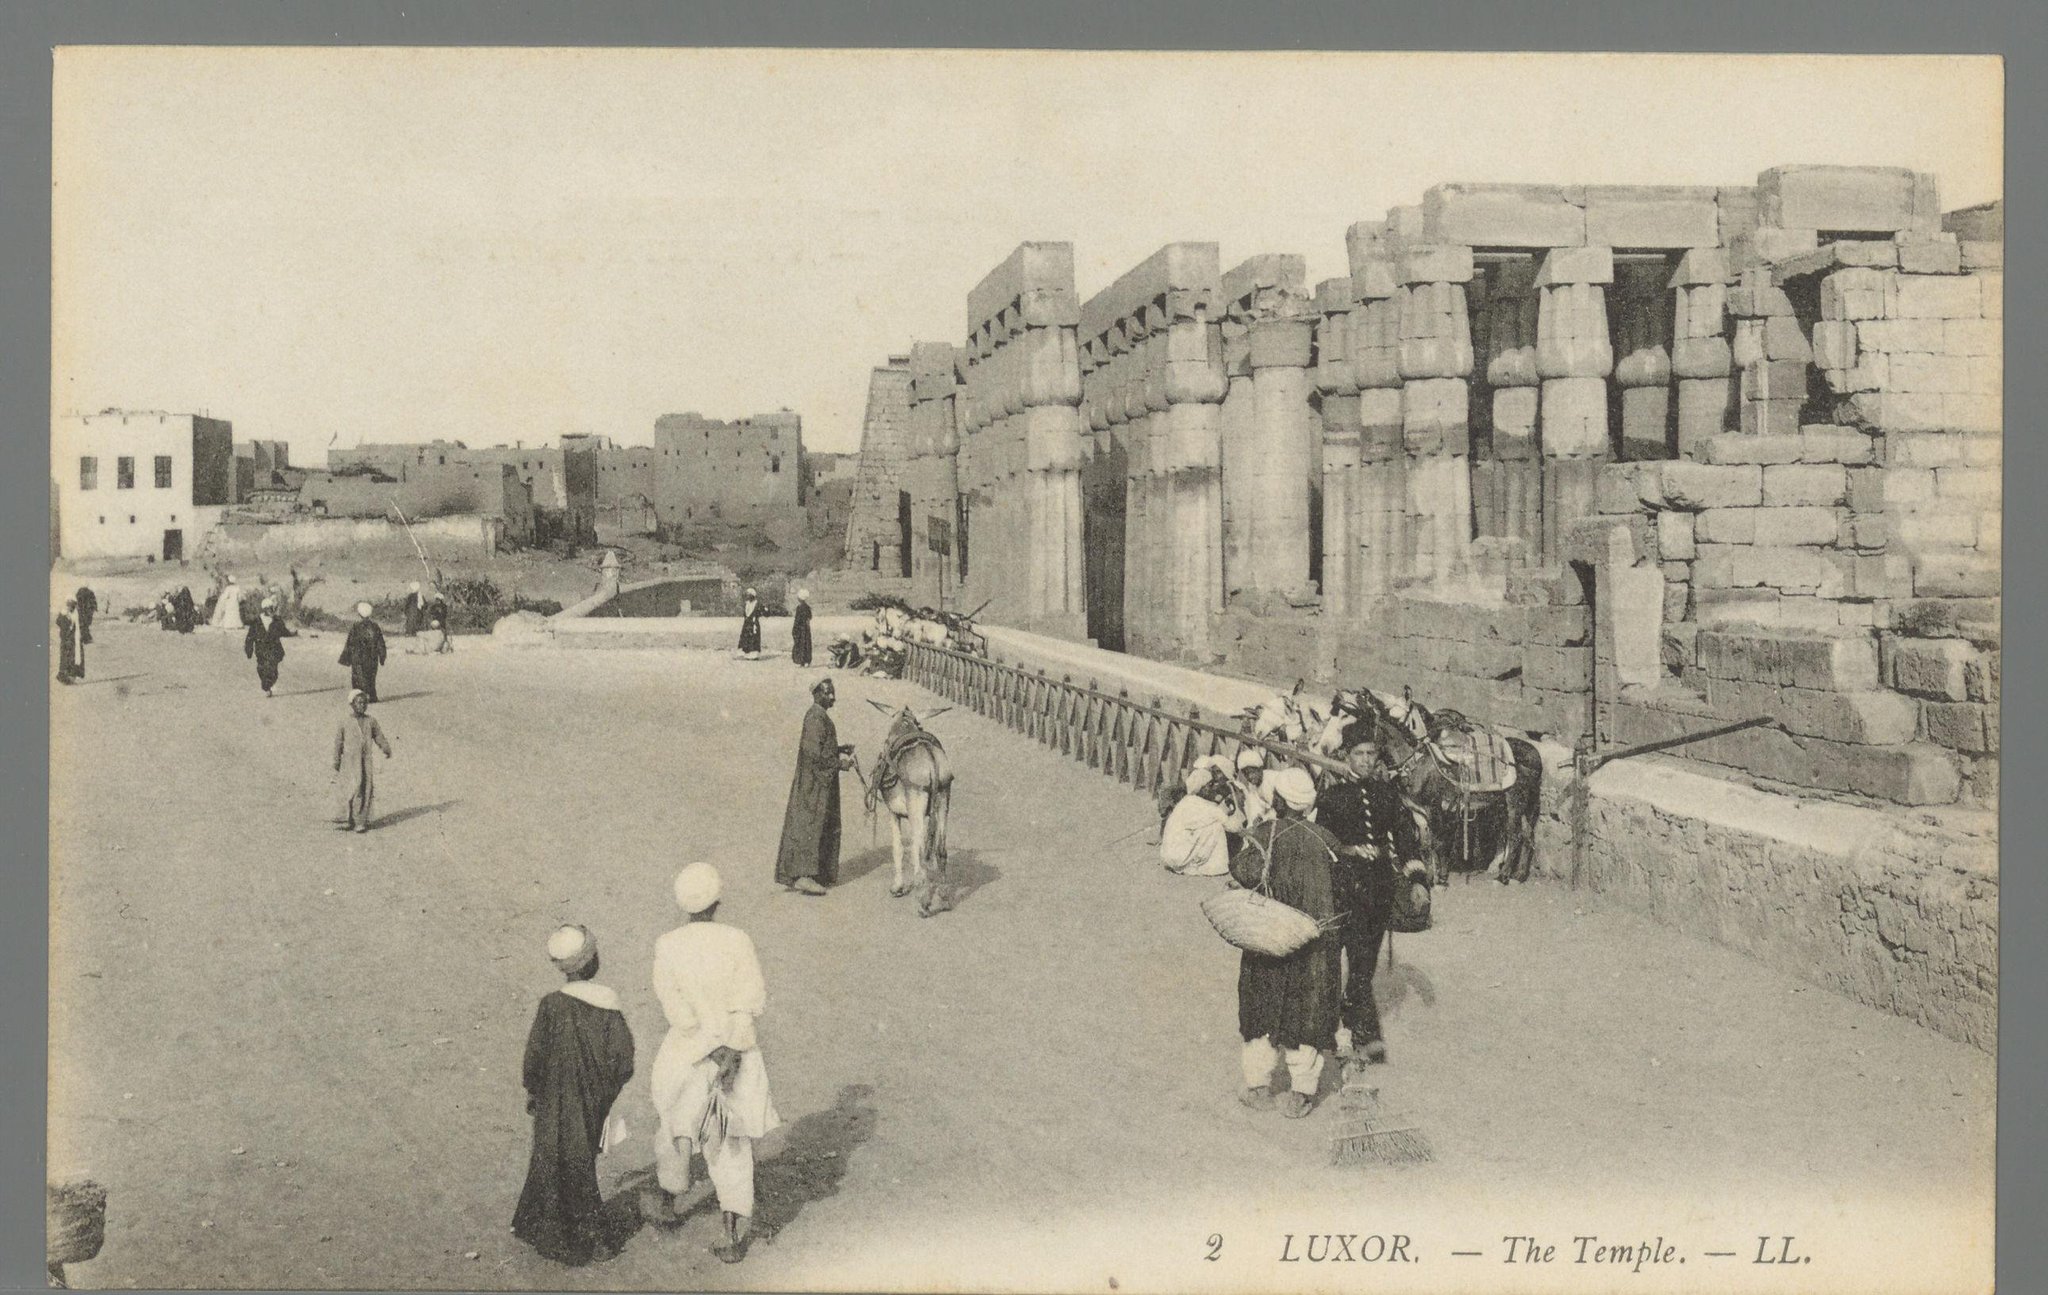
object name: ansichtkaart, prentbriefkaart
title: Luxor - The Temple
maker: Anonymous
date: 1907-1930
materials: cardboard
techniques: photograph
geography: luxor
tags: temple, shrine ~ egyptian religion